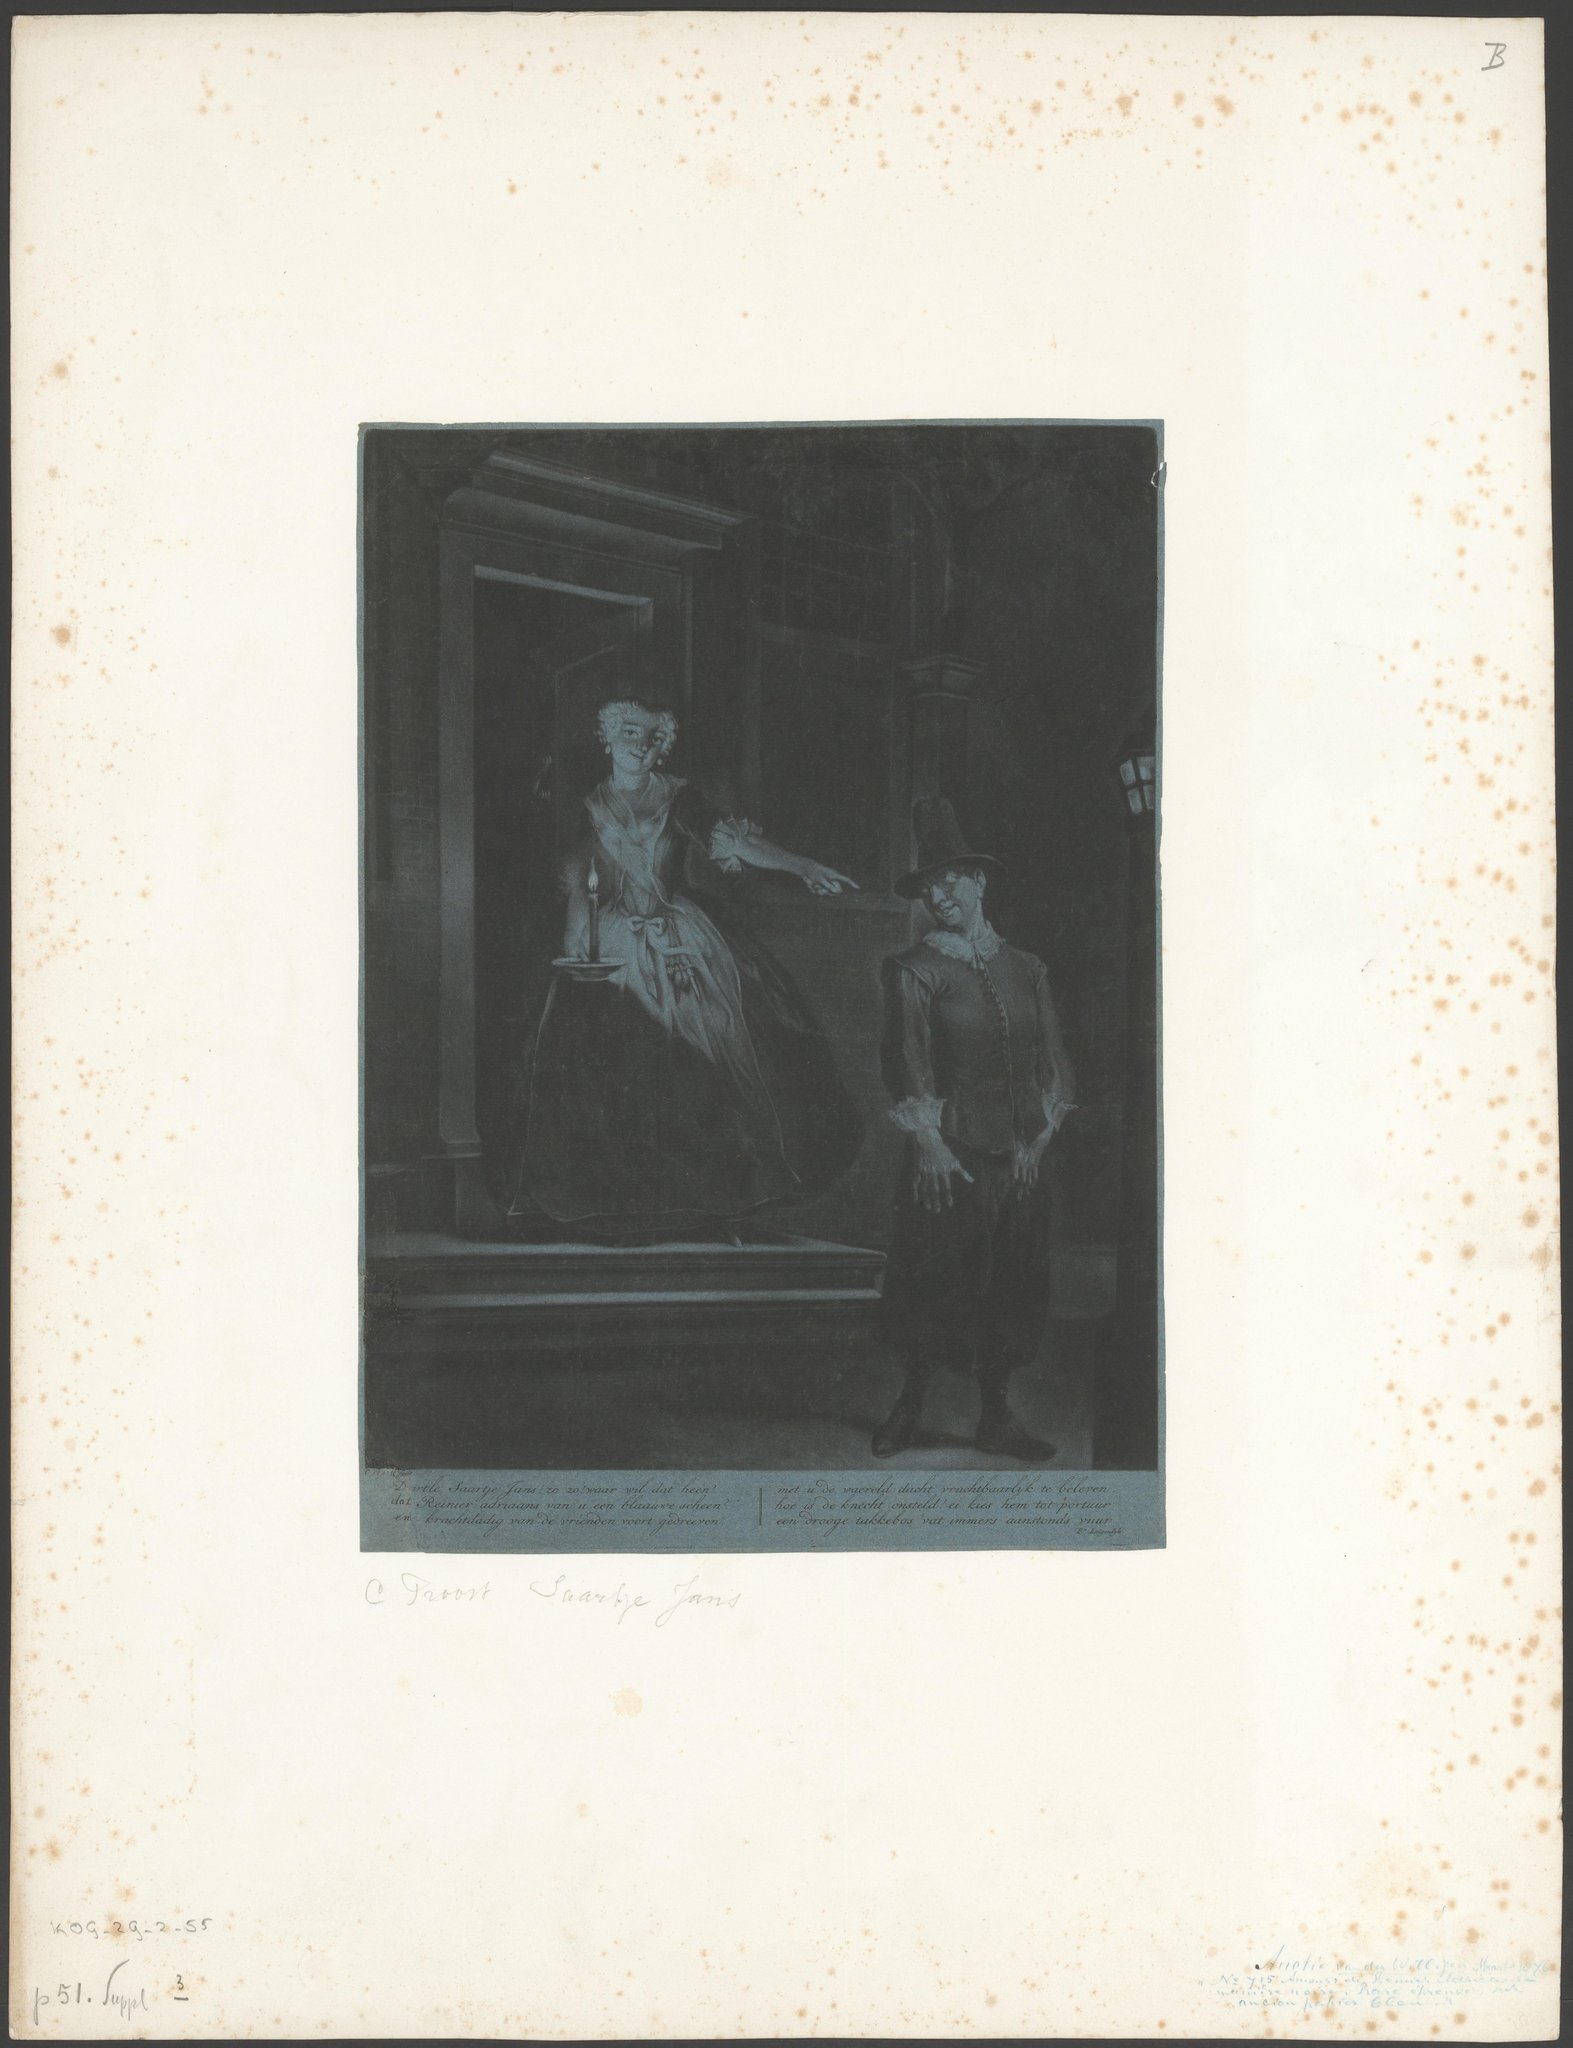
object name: print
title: Jan Claasz of de gewaande dienstmaagd: de liefdesverklaring van Reinier Adriaansz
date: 1706-1750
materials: paper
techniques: engraving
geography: amsterdam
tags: being refused, the proposal rejected, candle (+ kindling a light; lit, burning light, lamp, candle), comedy, night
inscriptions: collector's mark: Lugt 2488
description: Nachtgezicht. Reinier Adriaansz verklaart Saartje Jansz de liefde. Zij staat met een kaars in de deuropening. Met zesregelige tekst in de marge. Scène uit de komedie 'Jan Claasz of de gewaande dienstmaagd' van Thomas Asselijn.